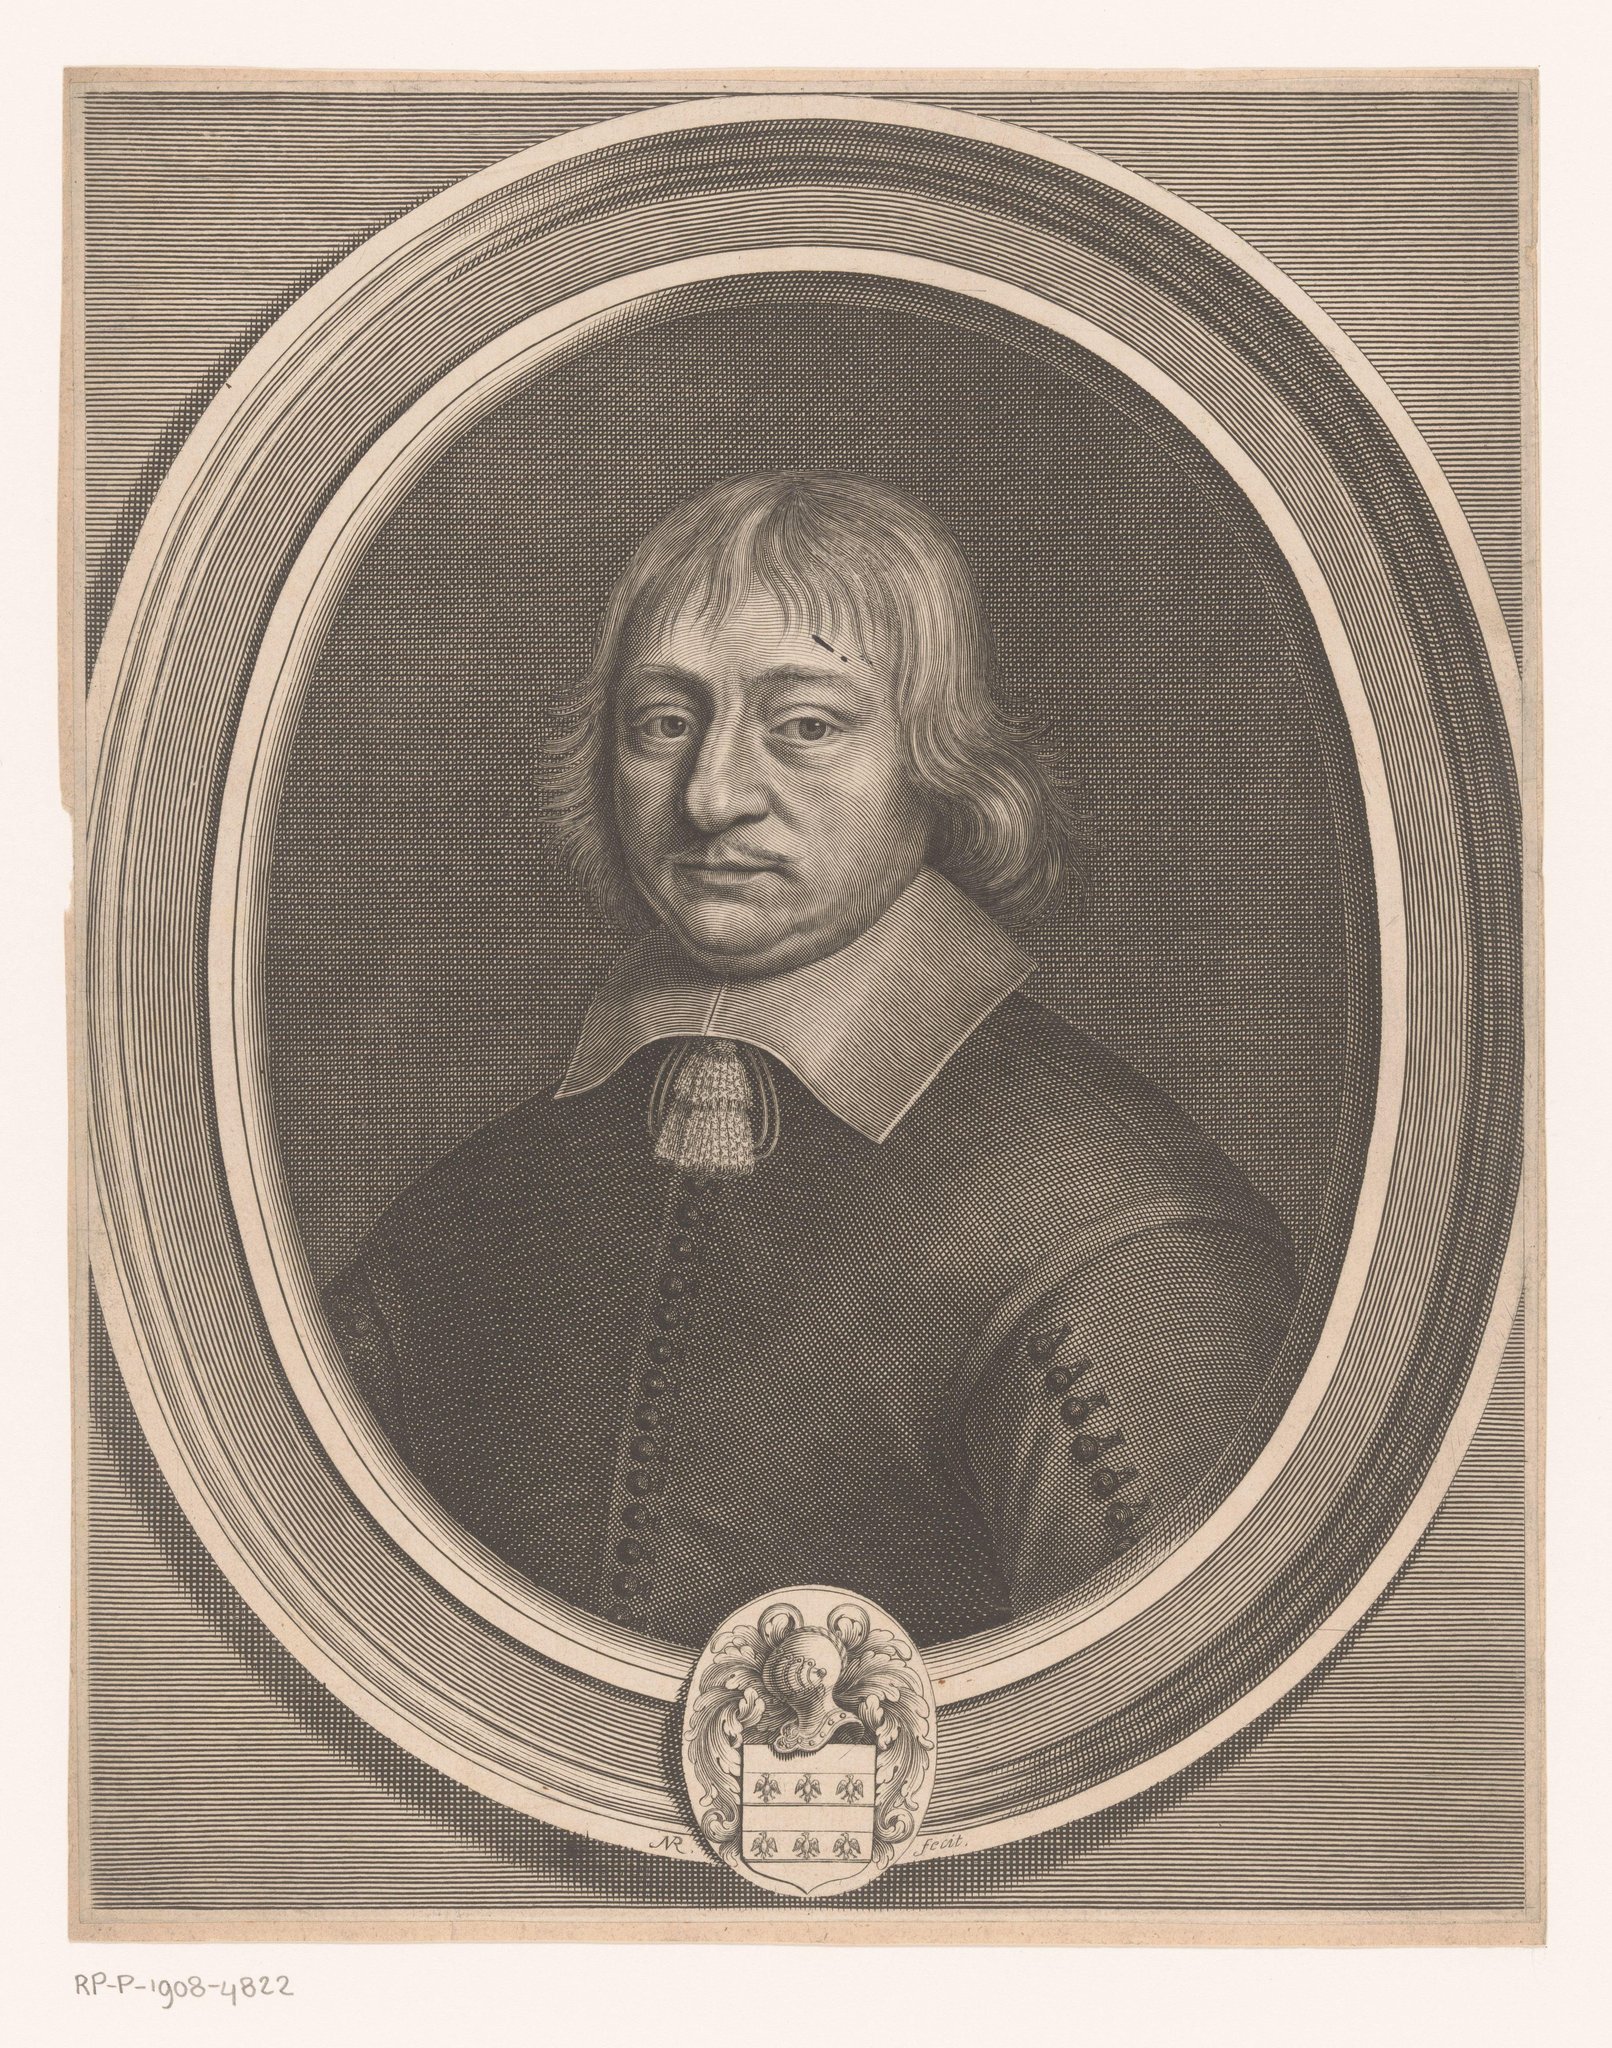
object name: print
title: Mansbuste in ovaal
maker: nicolas regnesson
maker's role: print maker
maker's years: 1620-1670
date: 1630-1670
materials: paper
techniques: engraving, etching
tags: historical persons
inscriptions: collector's mark: Lugt 2228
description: Onder zijn beeltenis een wapenschild met zes adelaars.